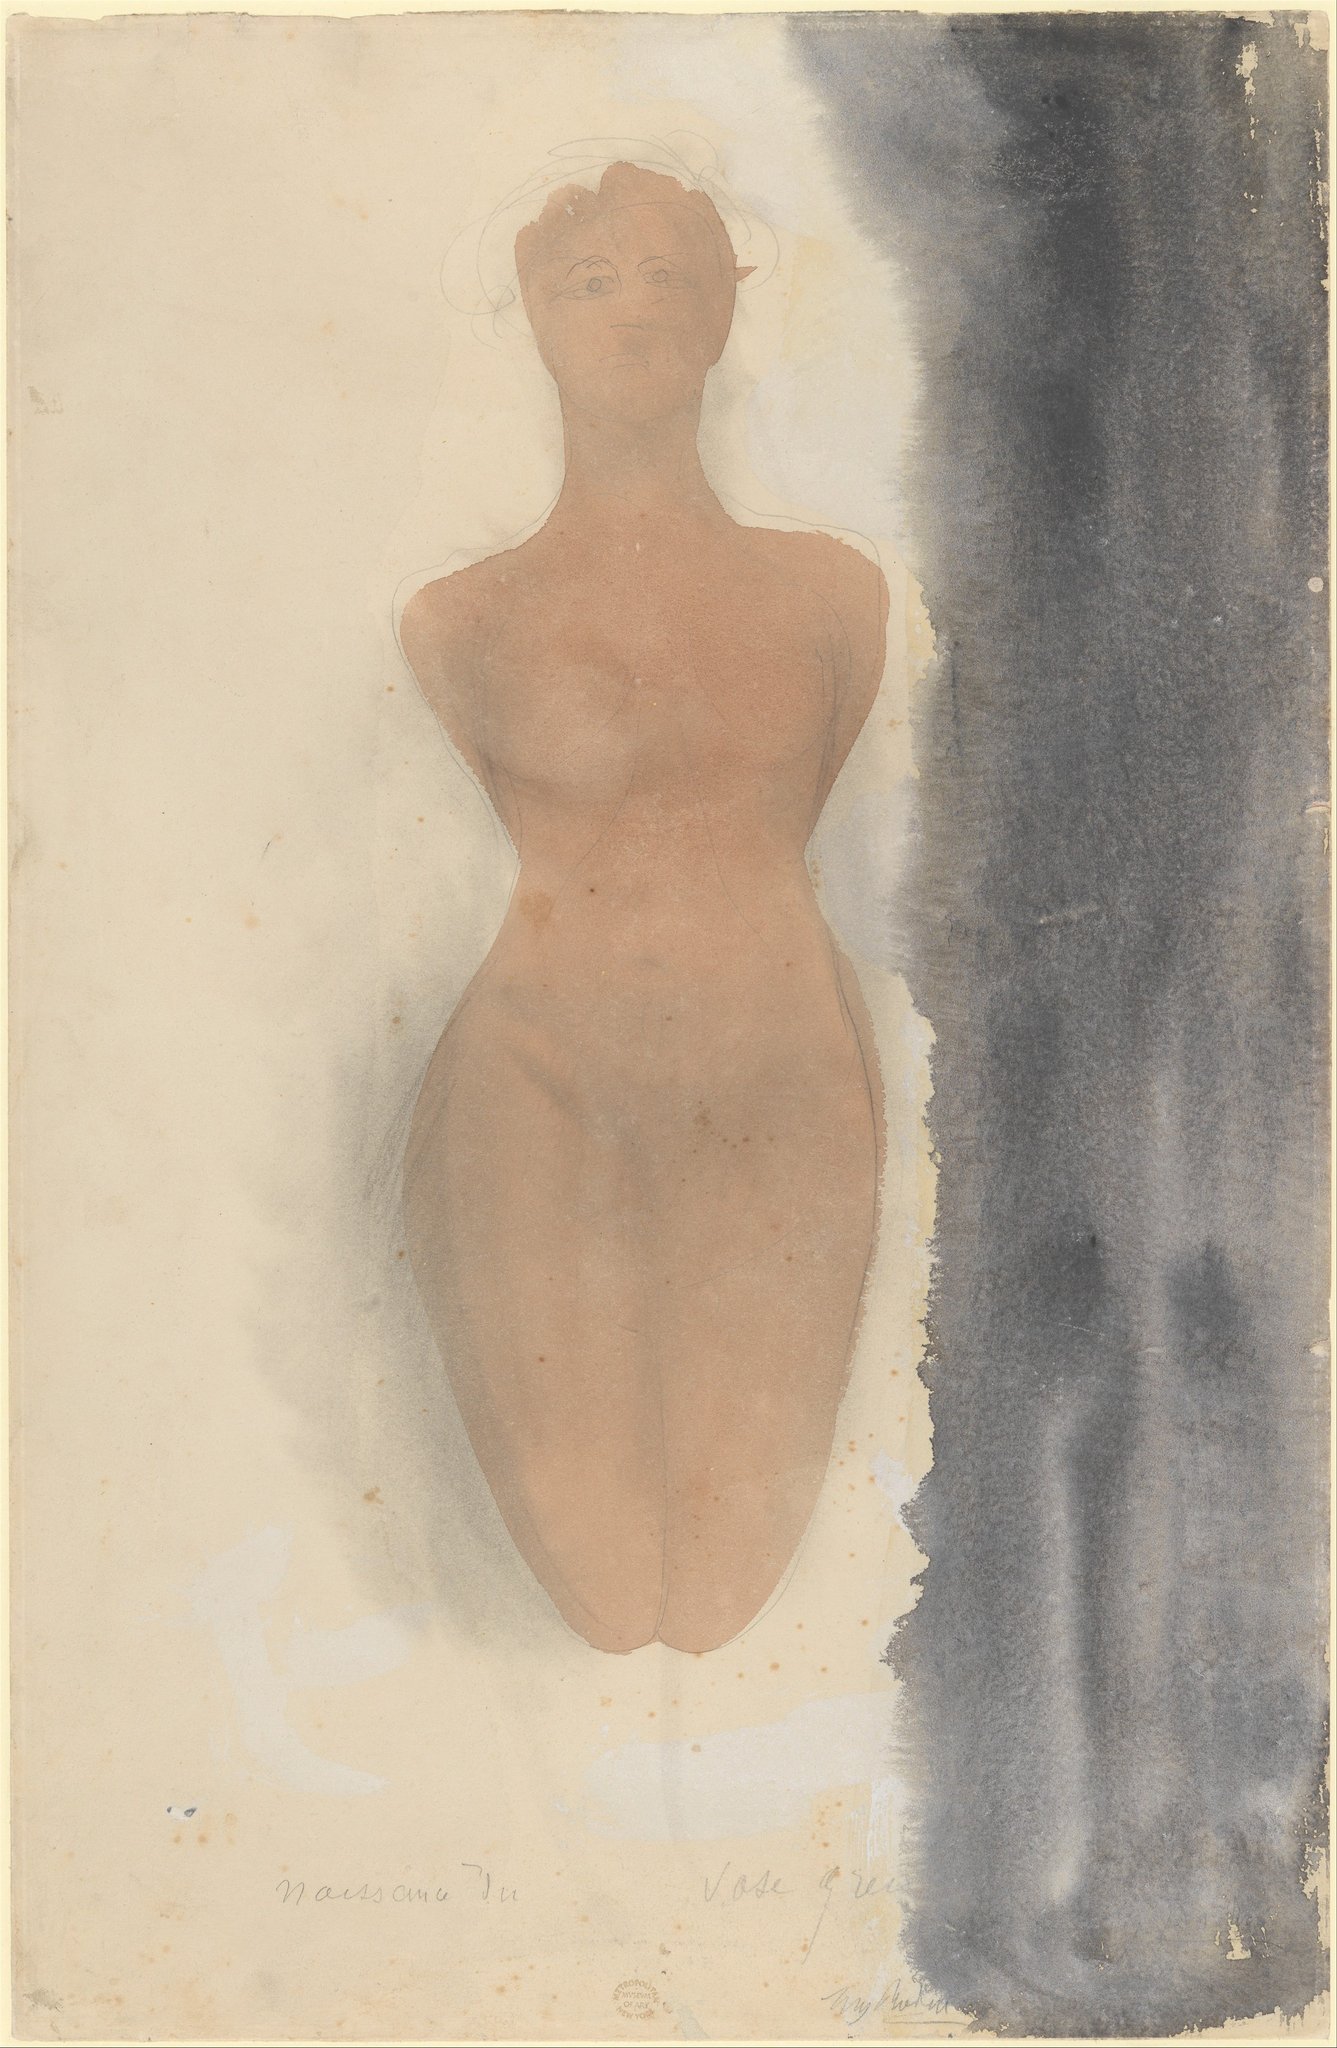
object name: drawing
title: Origin of the Greek Vase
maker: auguste rodin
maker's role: artist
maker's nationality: french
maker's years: 1840-1917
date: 1900-1910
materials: gouache, graphite, watercolor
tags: female nudes